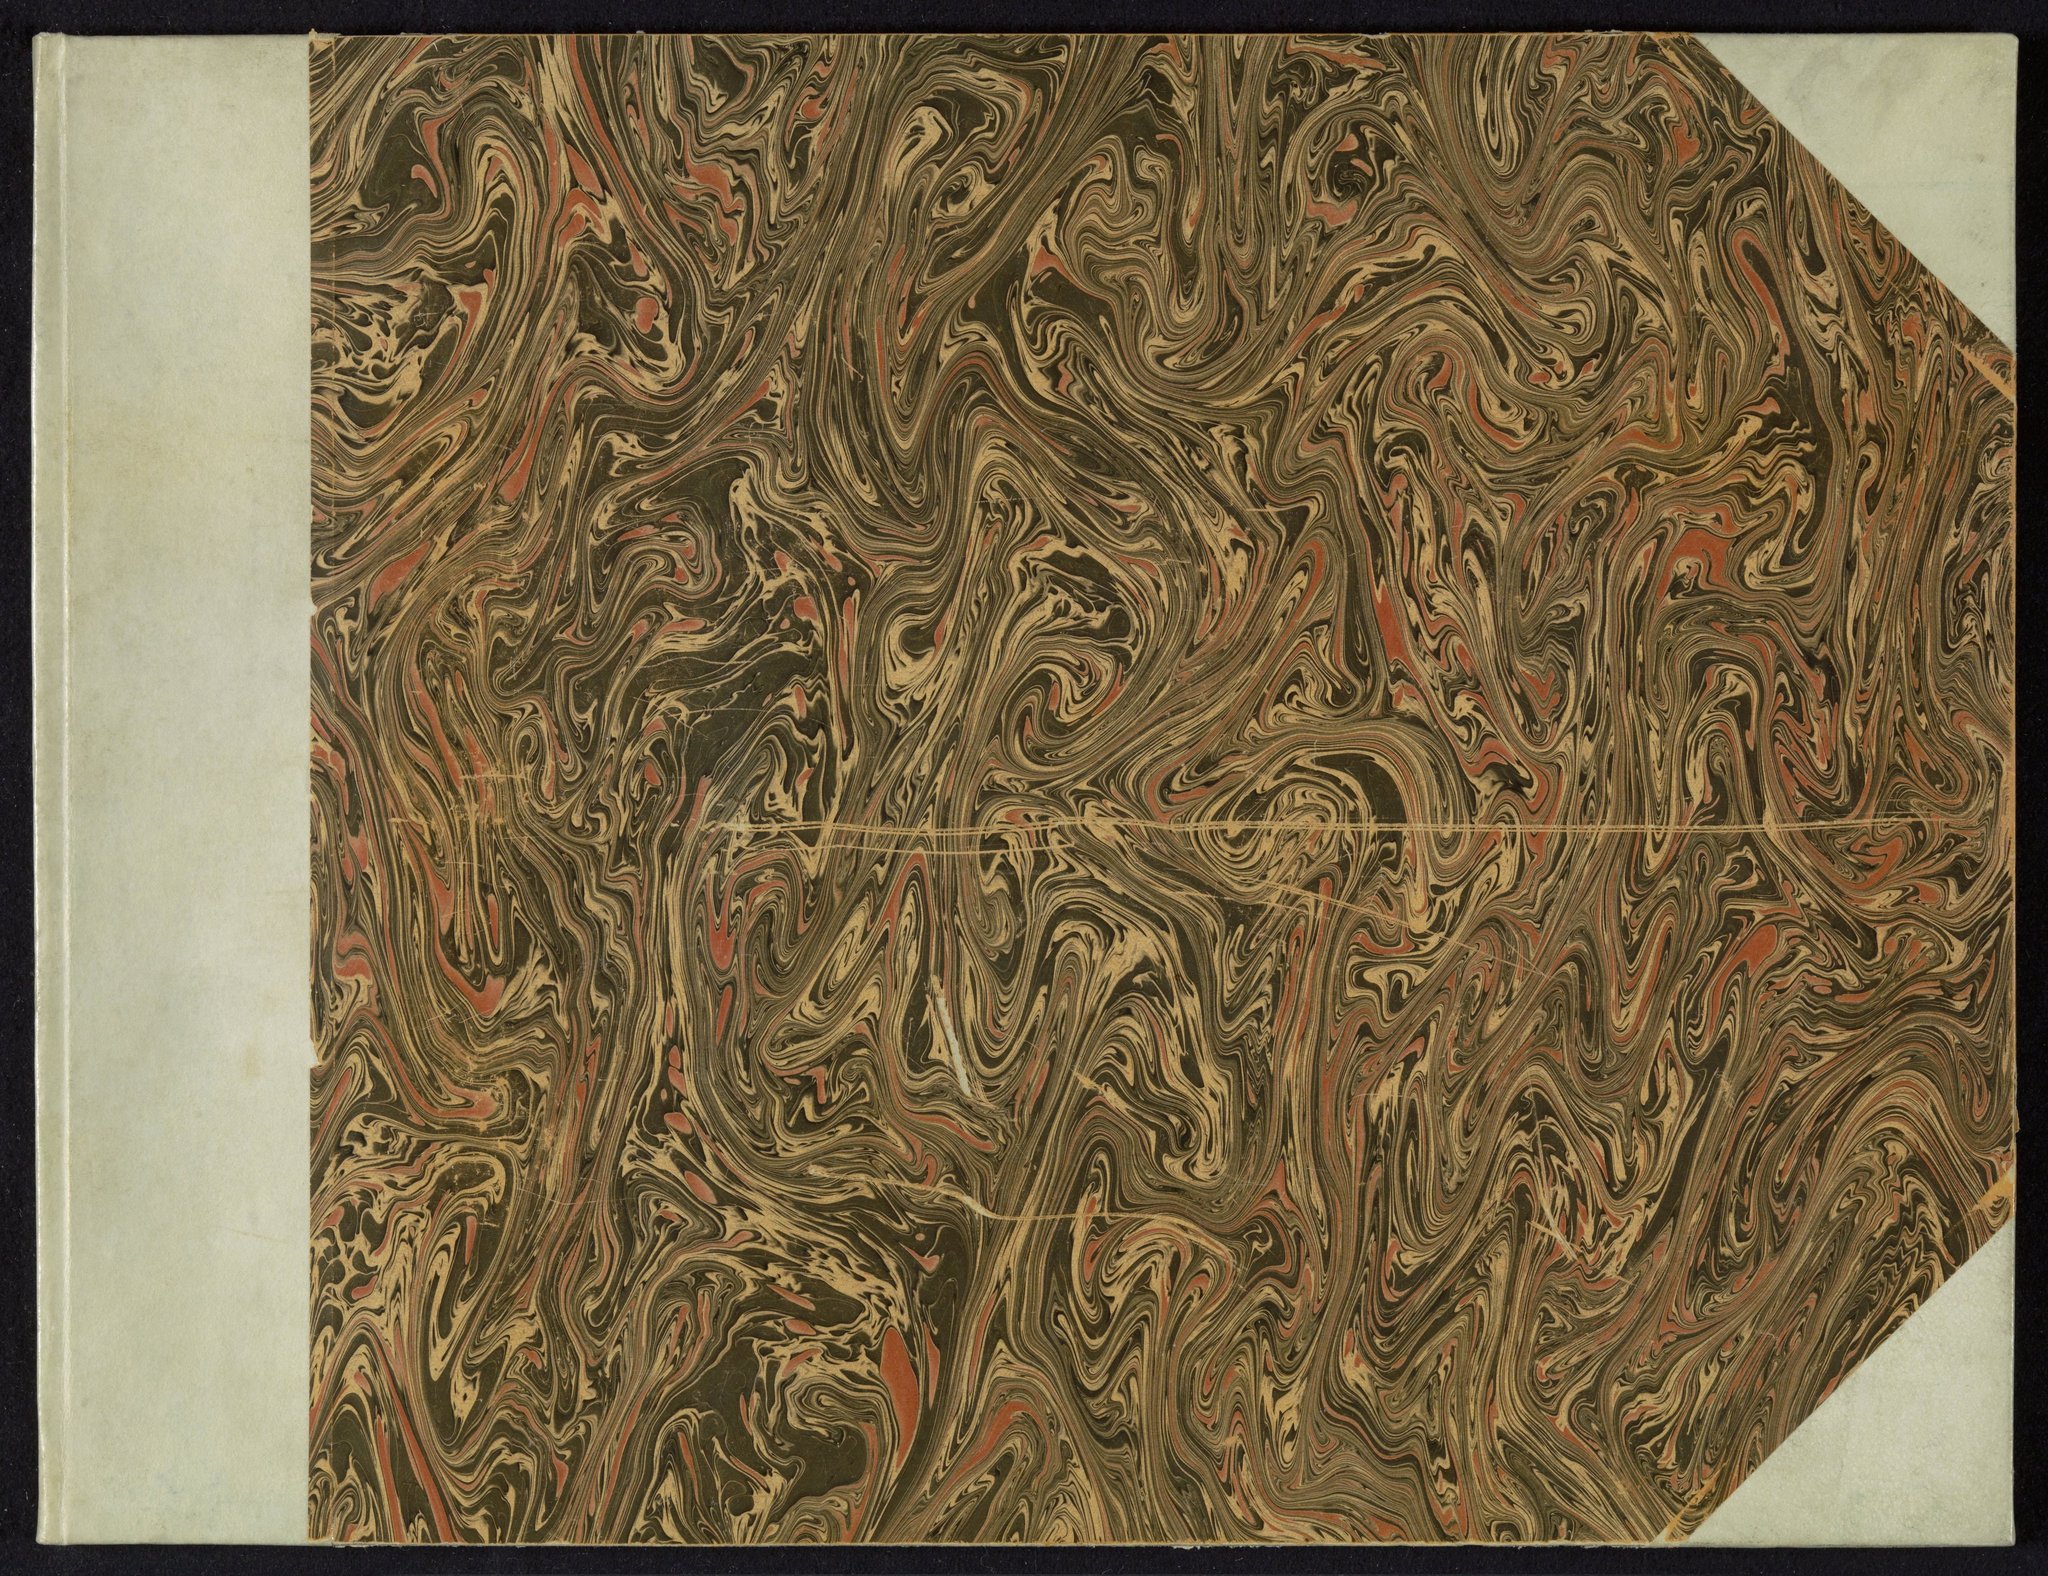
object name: prentrecueil, prentenalbum, prentalbum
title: Joh. Vredeman de Vries Hortorum Formae 1615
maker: johann bussemacher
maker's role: print maker, printer, publisher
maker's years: -1627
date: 1615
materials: paper, parchment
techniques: bookbinding, etching, marbling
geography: cologne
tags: garden, french or architectonic garden; formal garden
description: Album met vijftien voorstellingen op vijftien albumbladen. Het gaat om een kopie van het titelblad en negen (van achttien) kopieën van perspectivische afbeeldingen van tuinen geassocieerd met de Dorische, Ionische en Korinthische bouworden naar ontwerp van Hans Vredeman de Vries, verschenen in 1583 onder de titel: Hortorum Viridariorumque elegantes et multiplicis formae. Toegevoegd zijn zes kopieën van voorstellingen uit een reeks van acht tuinen naar ontwerp van Vredeman de Vries verschenen in 1587. Half perkamenten band met gemarmerde platten, voorin en achterin een schutblad.